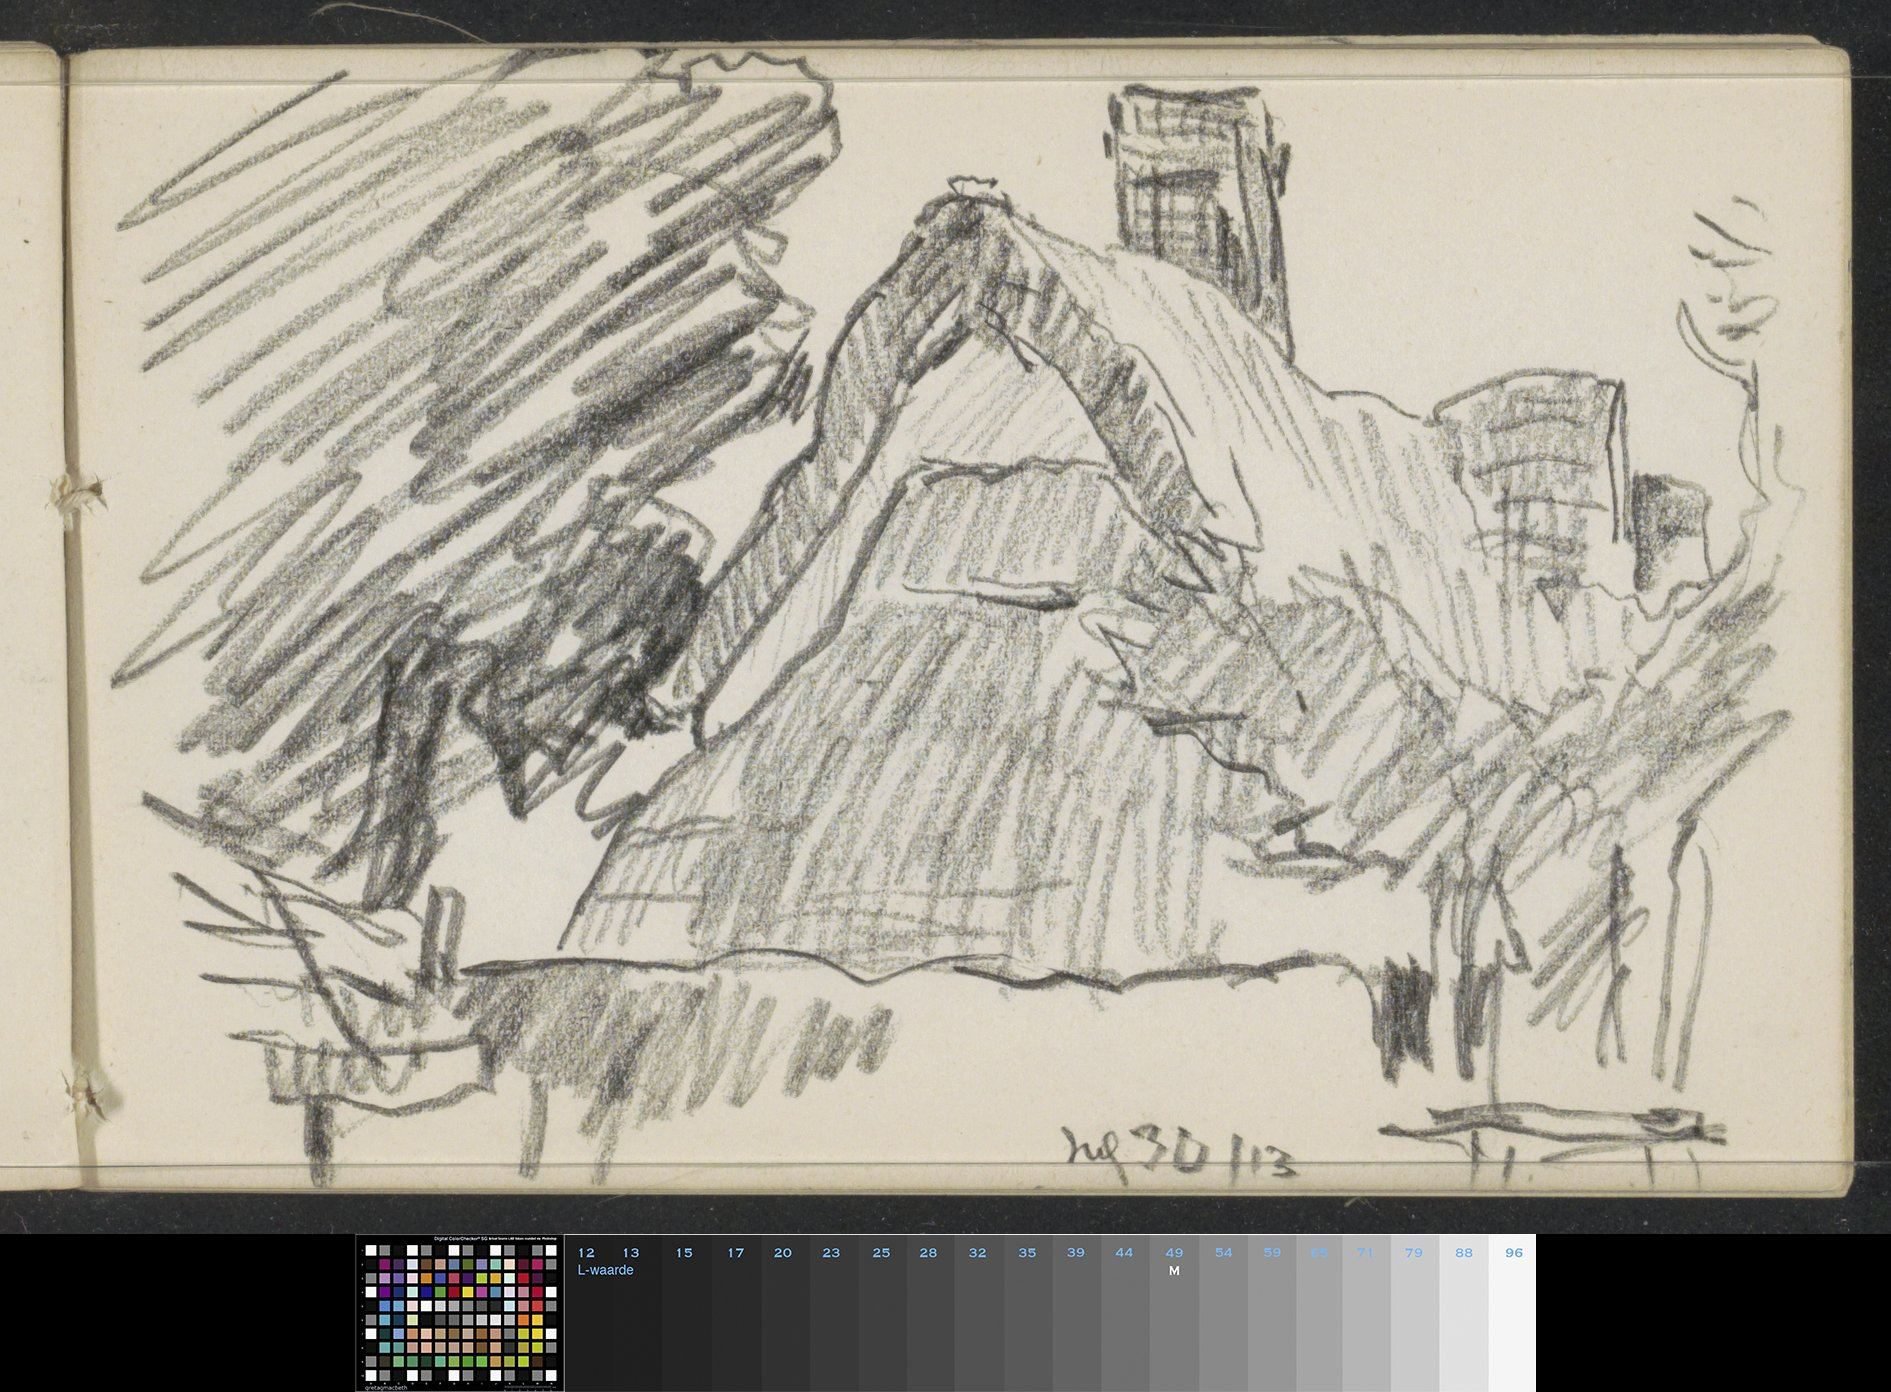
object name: sketchbook leaf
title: Boerderij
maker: alexander shilling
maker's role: draughtsman, print maker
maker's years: 1859-1937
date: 1907-1913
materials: chalk, paper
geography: dedham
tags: farm (building)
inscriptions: date: ‘Jul 30/13’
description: Blad 16 recto uit een schetsboek met 30 bladen.